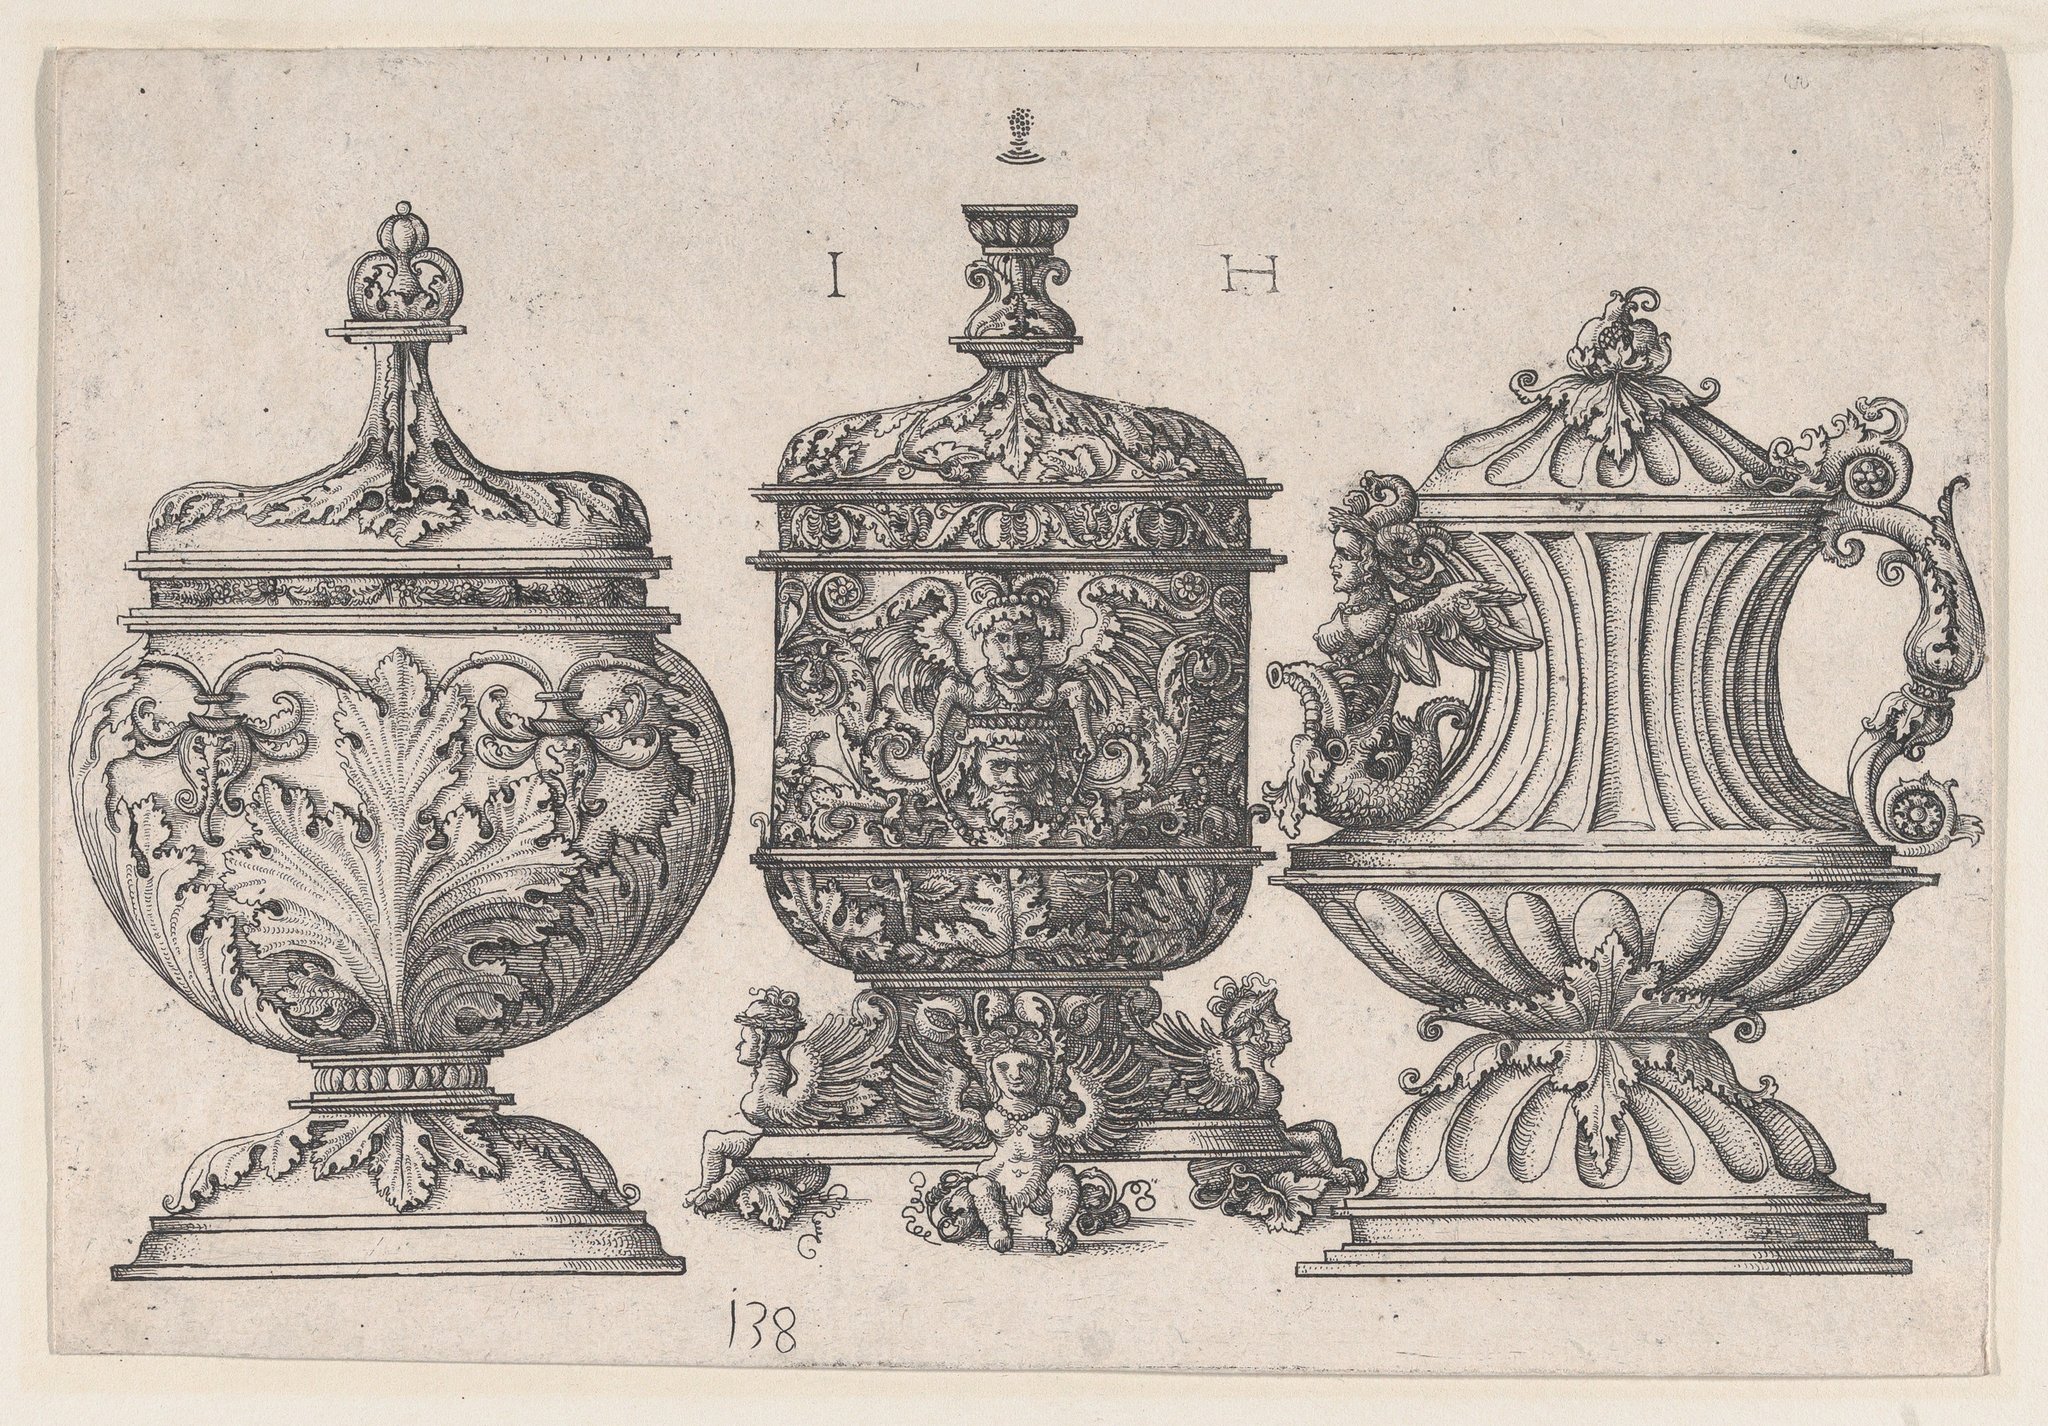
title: Three Goblets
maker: hieronymus hopfer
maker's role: artist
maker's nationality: german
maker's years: 1500-1563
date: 1528-1563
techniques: etching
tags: goblets